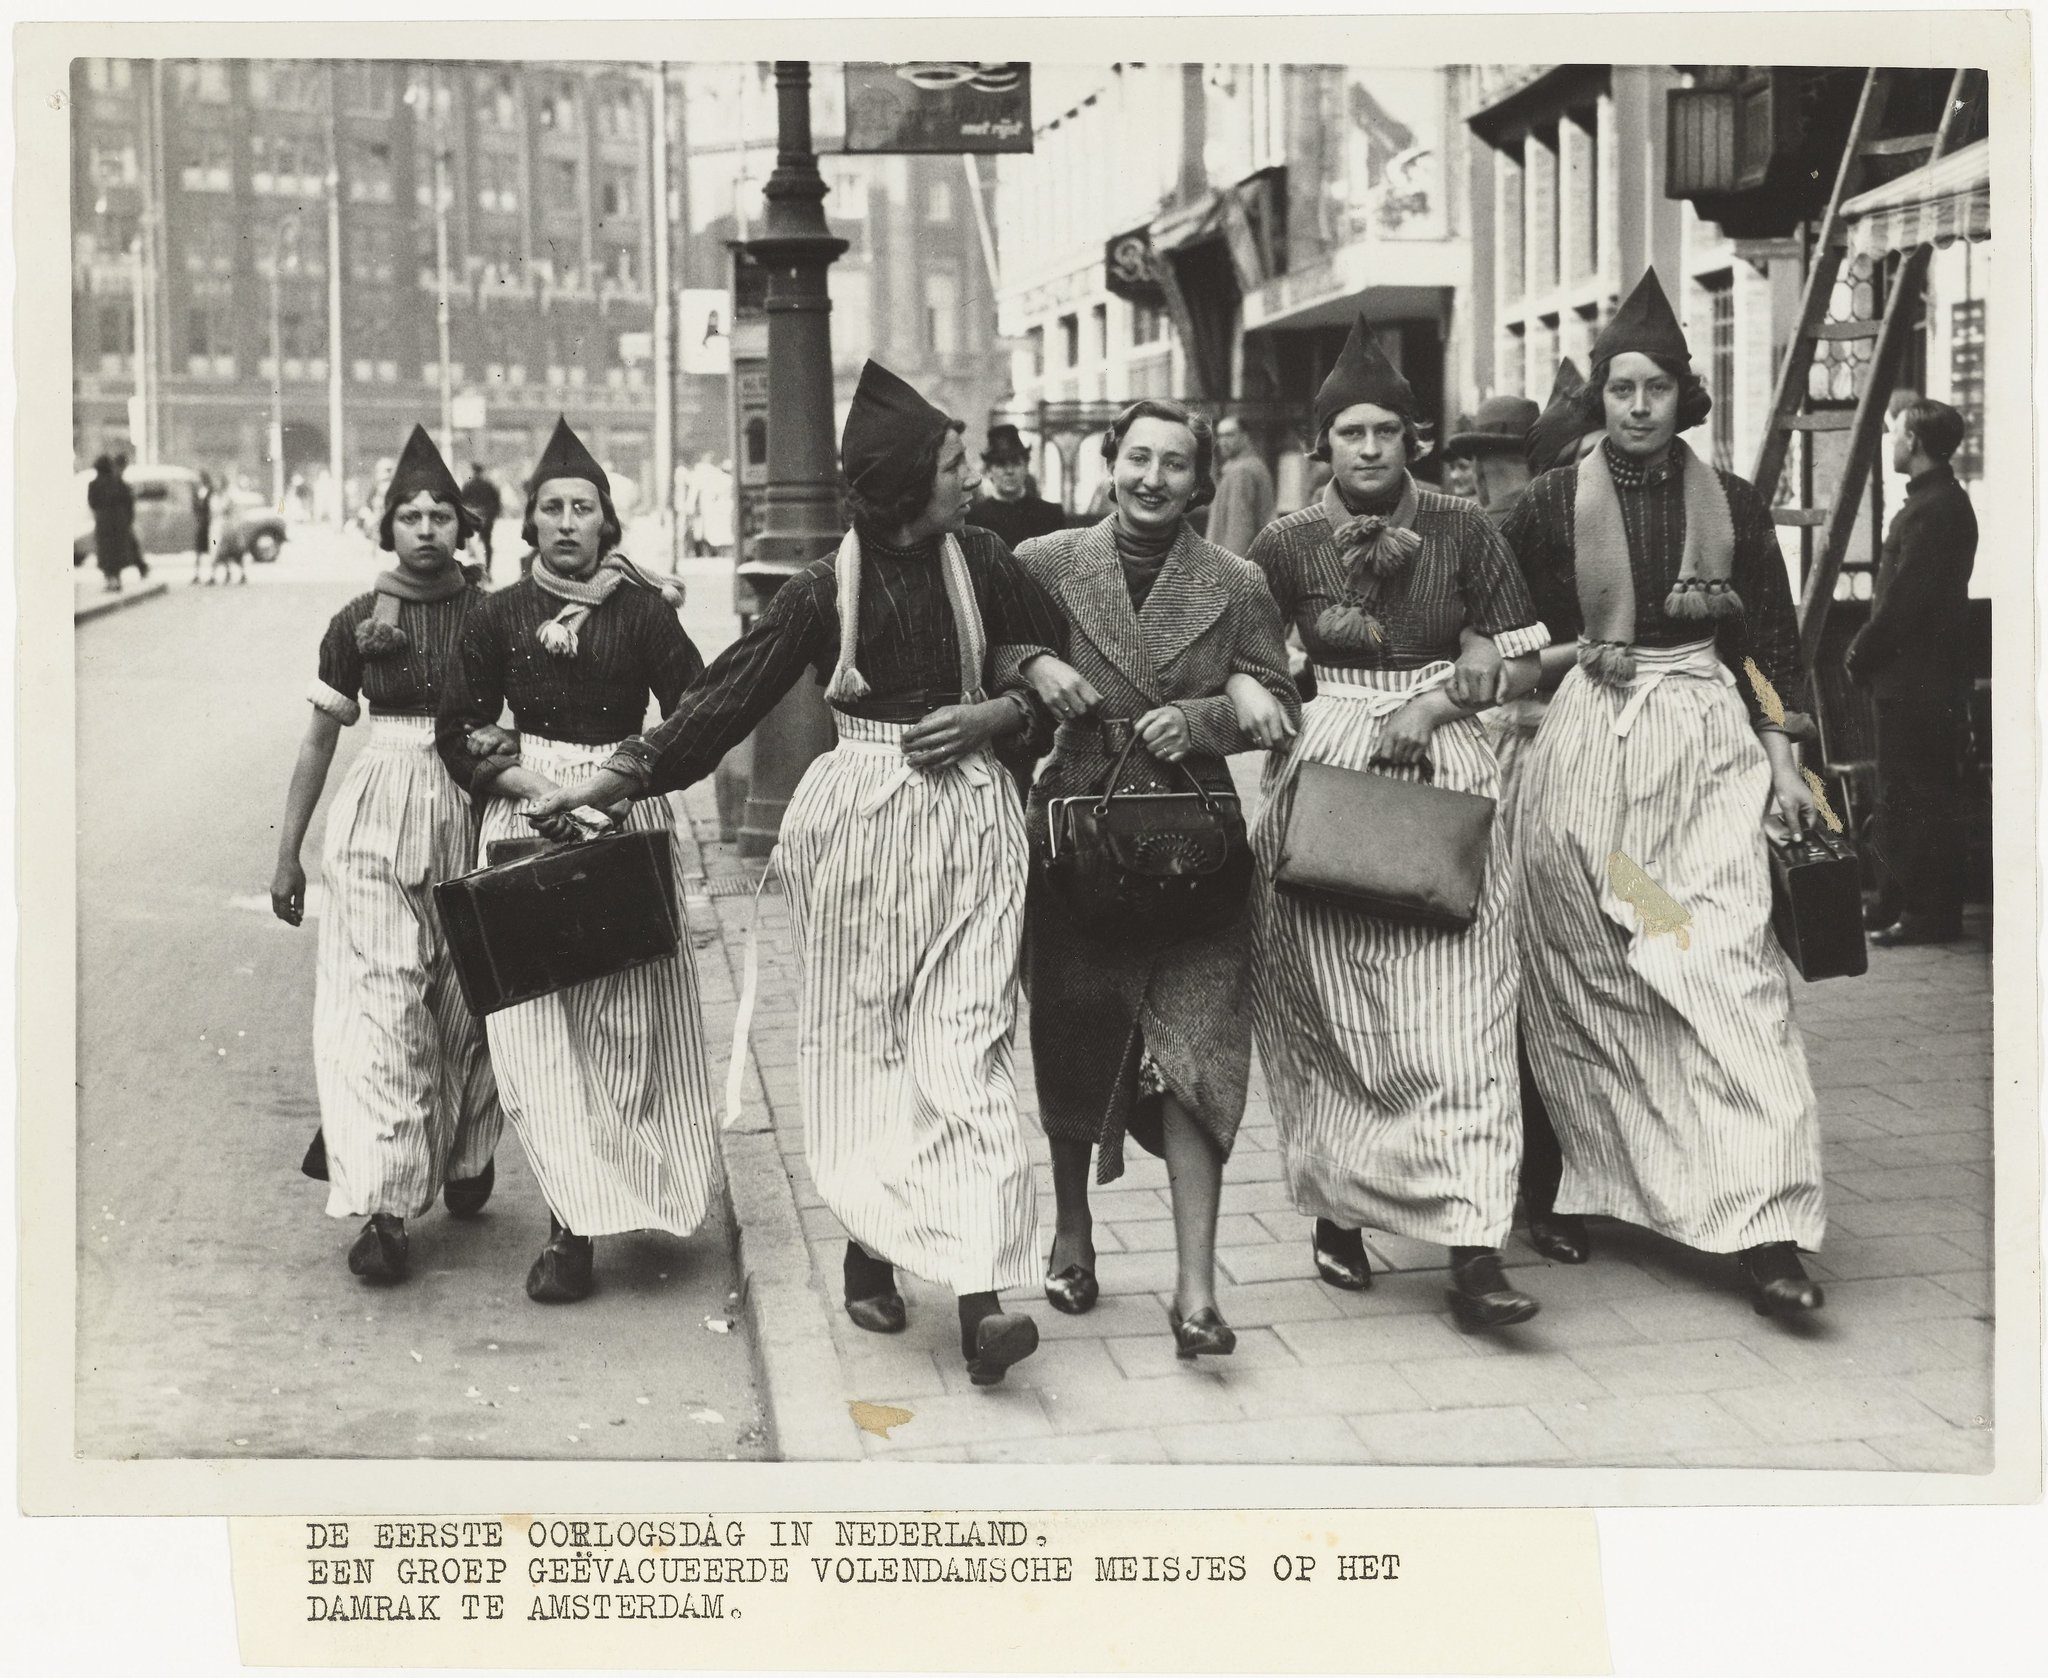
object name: photograph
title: Eerste oorlogsdag: Volendamse meisjes.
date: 1940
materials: photographic support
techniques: photography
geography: amsterdam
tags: soldiers and civilians, amsterdam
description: Op de eerste dag van de oorlog lopen geëvacueerde Volendamse meisjes over het Damrak. Tekststrookje aan foto geplakt.